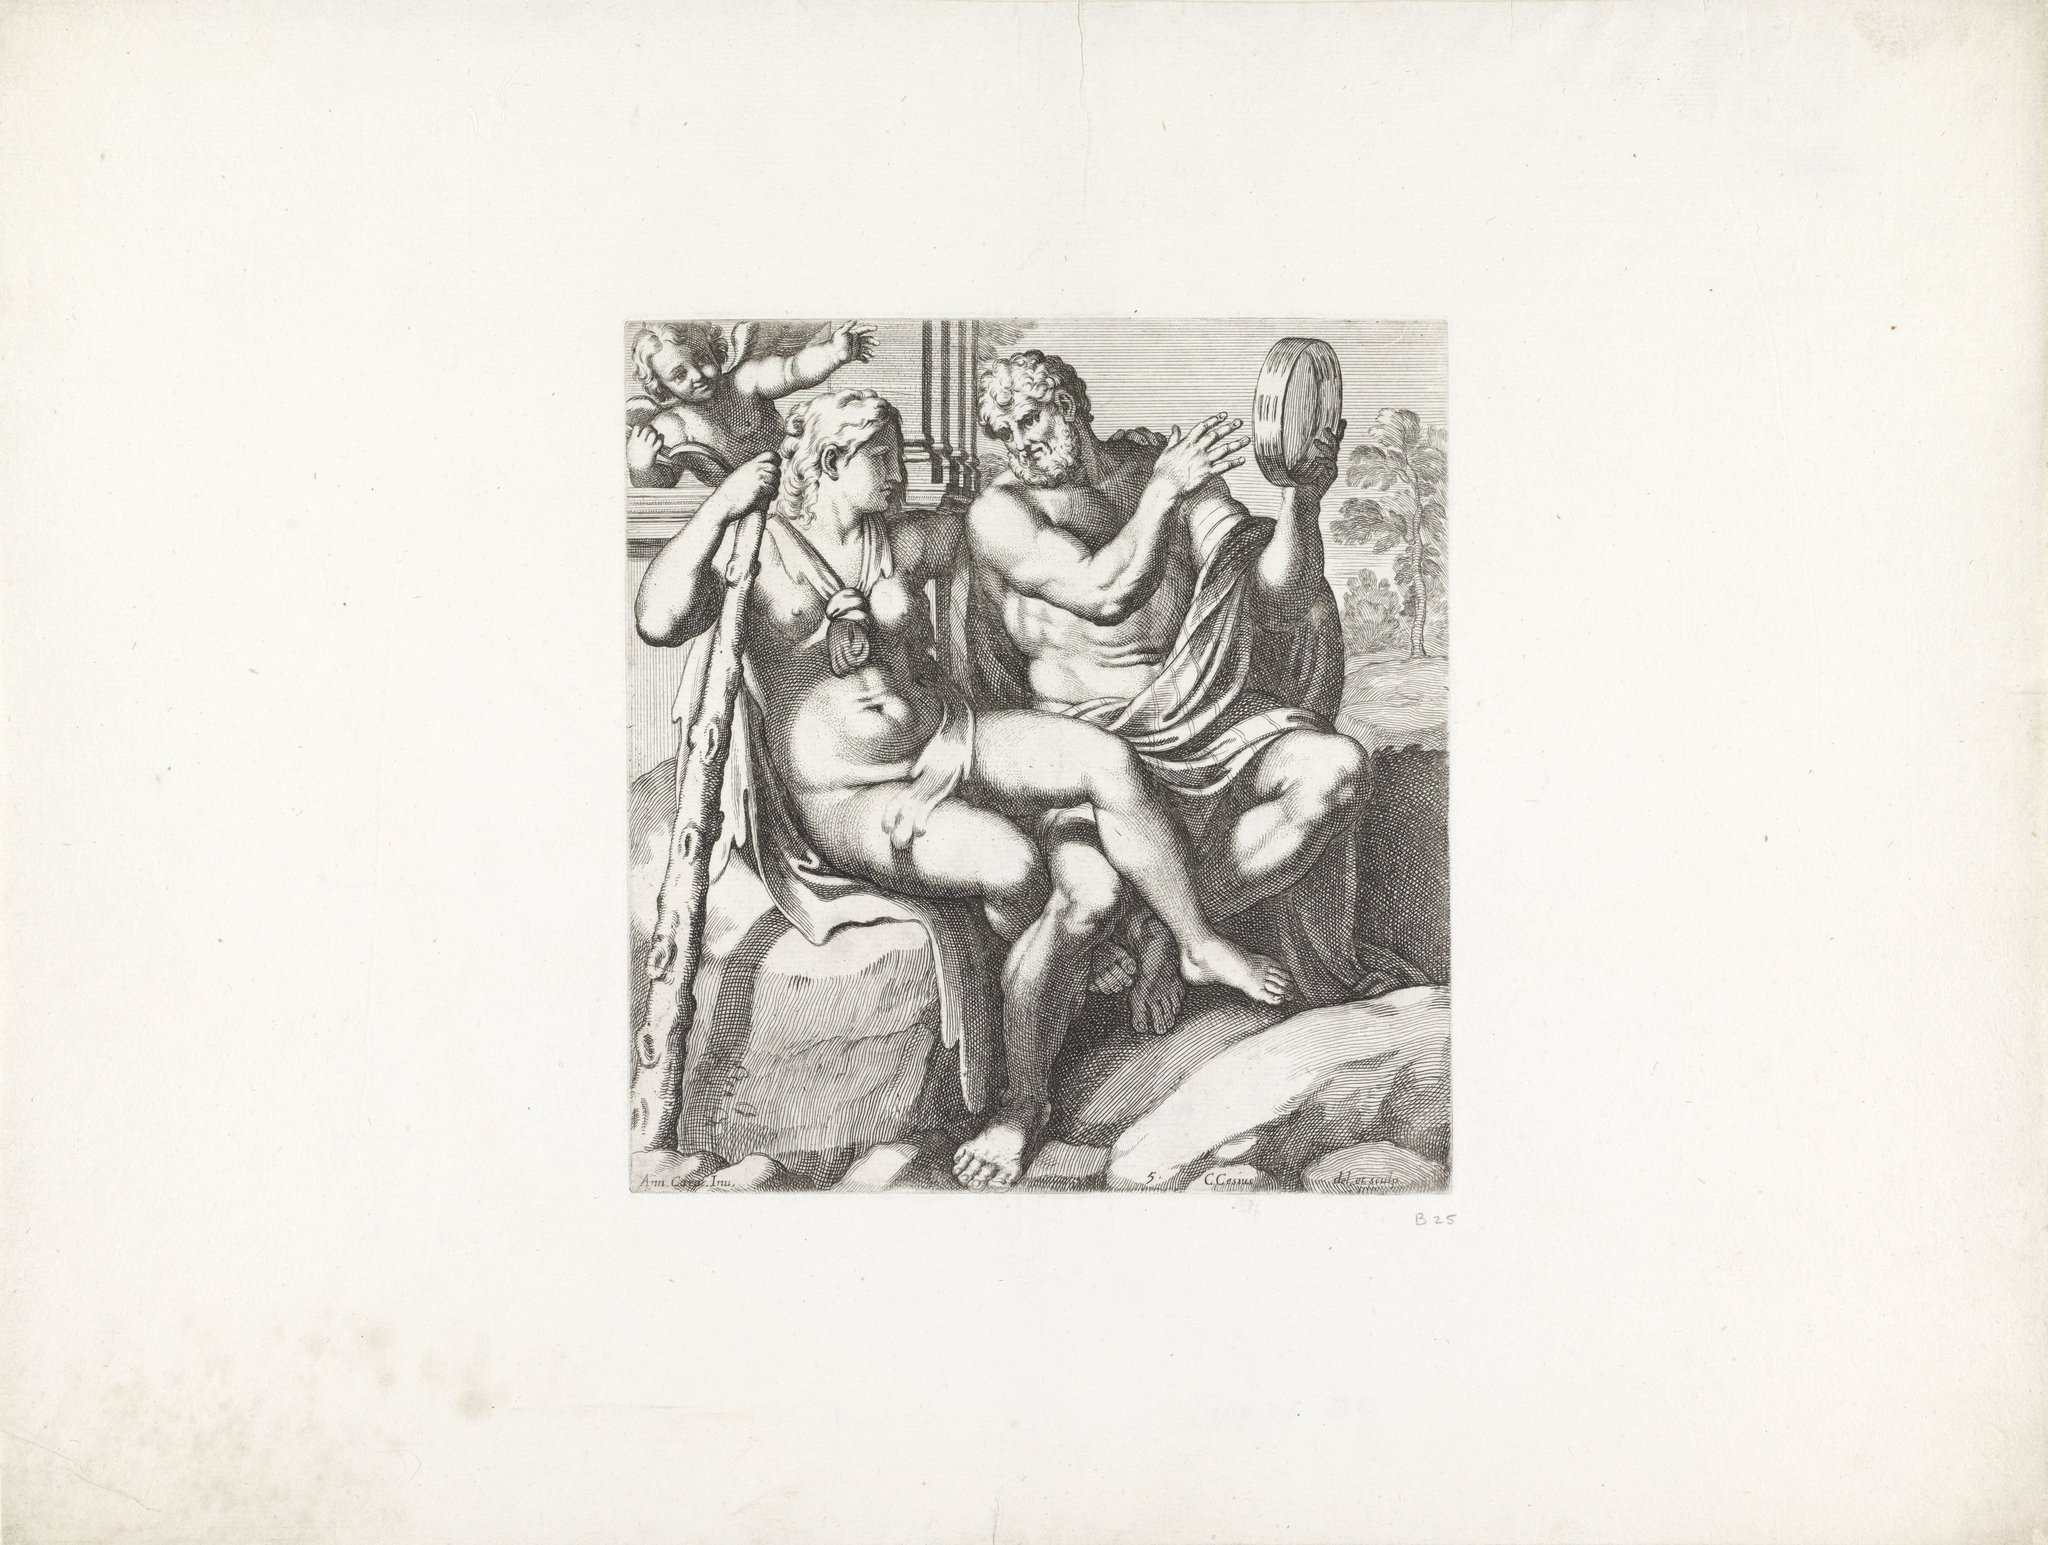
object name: print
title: Schilderingen in Palazzo Farnese te Rome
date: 1656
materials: paper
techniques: etching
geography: vatican city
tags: hercules wooing iole, (story of) cupid, amor (eros)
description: Prent uit een reeks prenten met nummers van 1 tot en met 29 (sommige prenten hebben hetzelfde nummer), plus titelprent en opdracht, naar schilderingen in Palazzo Farnese te Rome.